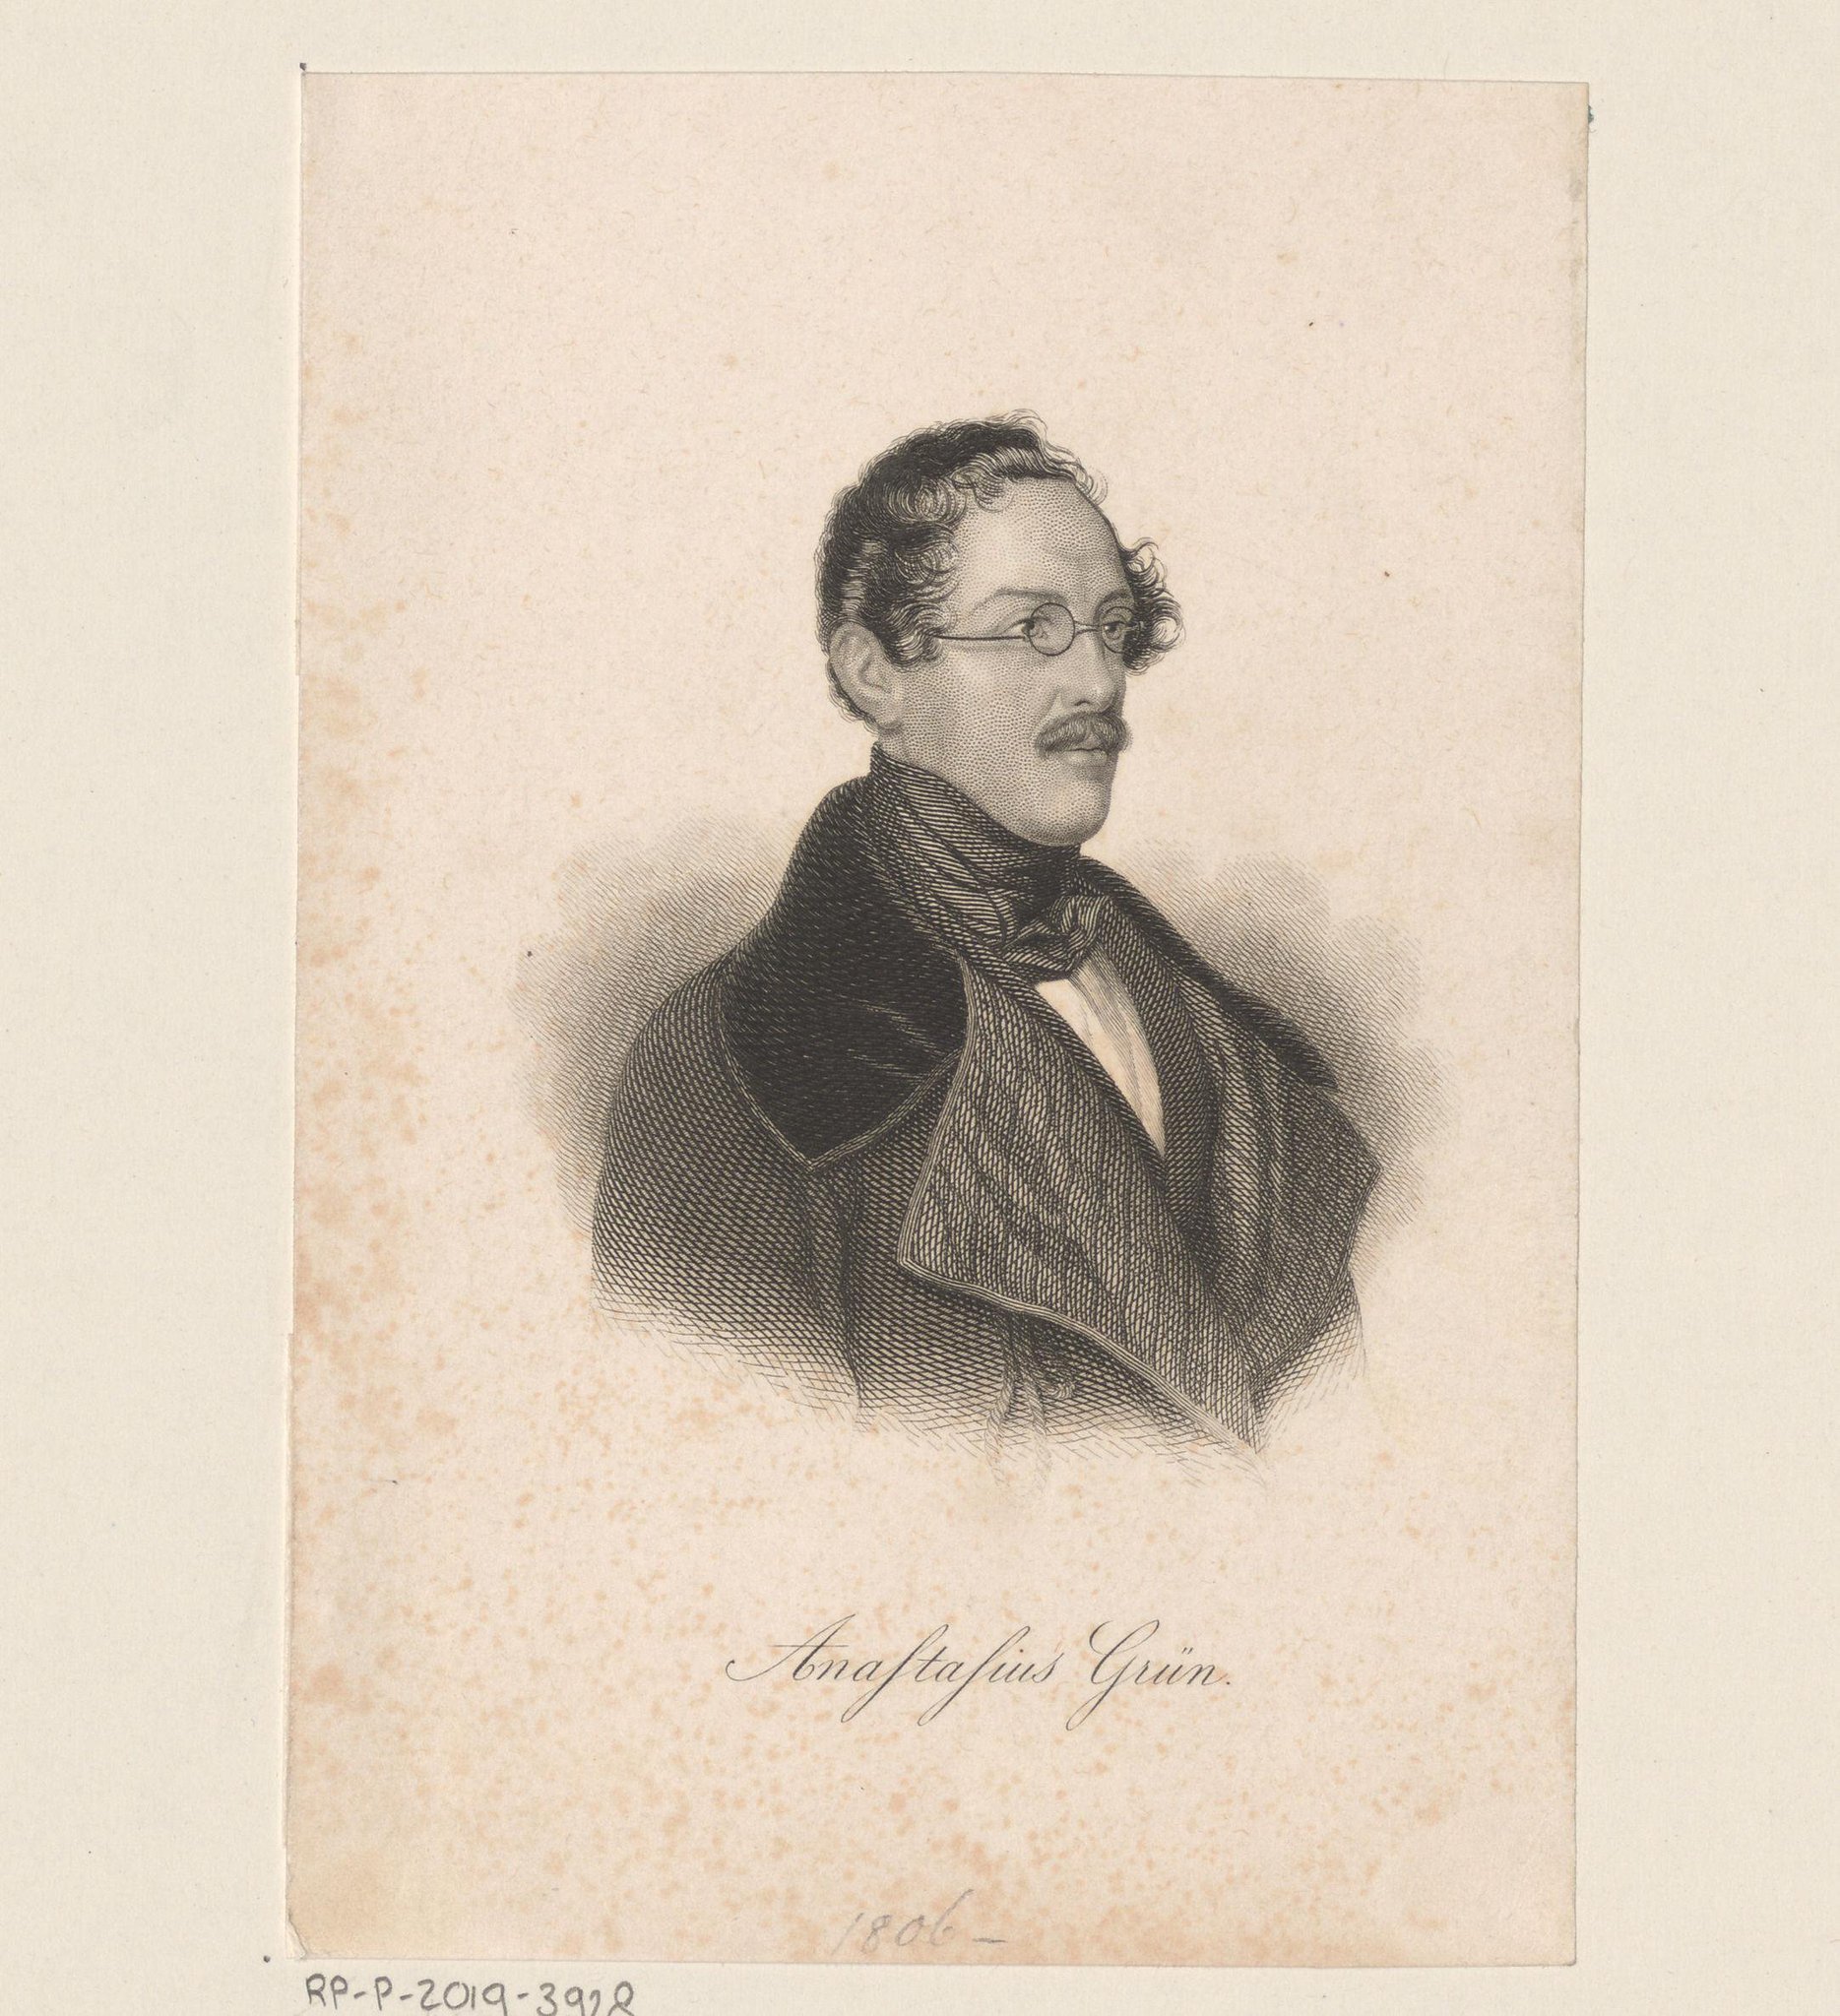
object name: print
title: Portret van Anton Alexander von Auersperg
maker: Anonymous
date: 1830-1880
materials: paper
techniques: engraving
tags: historical persons, writer, poet, author